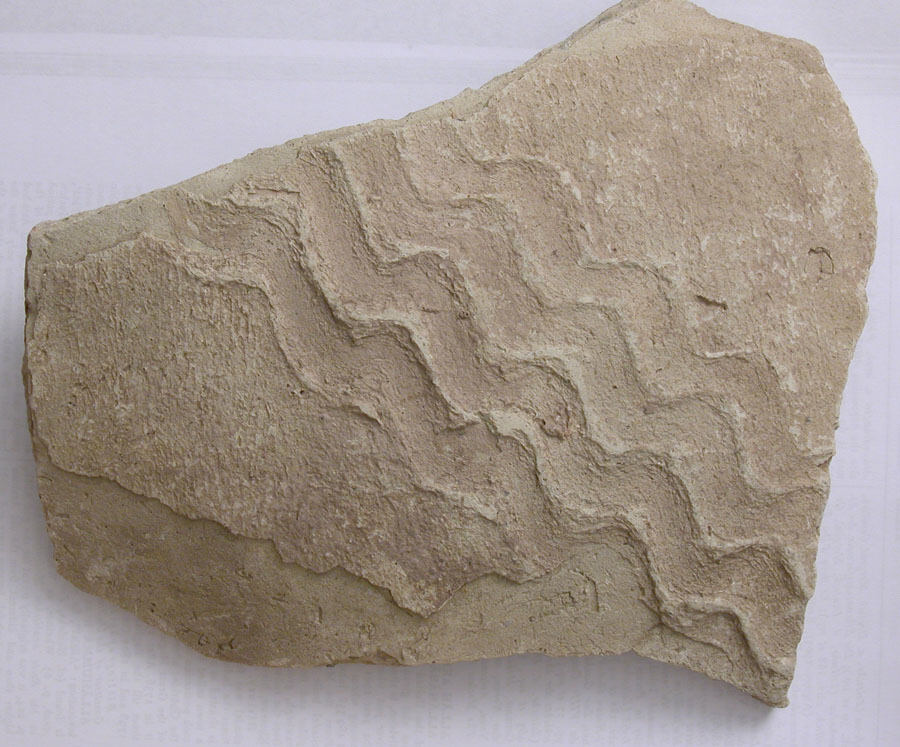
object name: fragment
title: Ceramic Fragment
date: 701-900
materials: earthenware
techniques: molding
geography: iraq